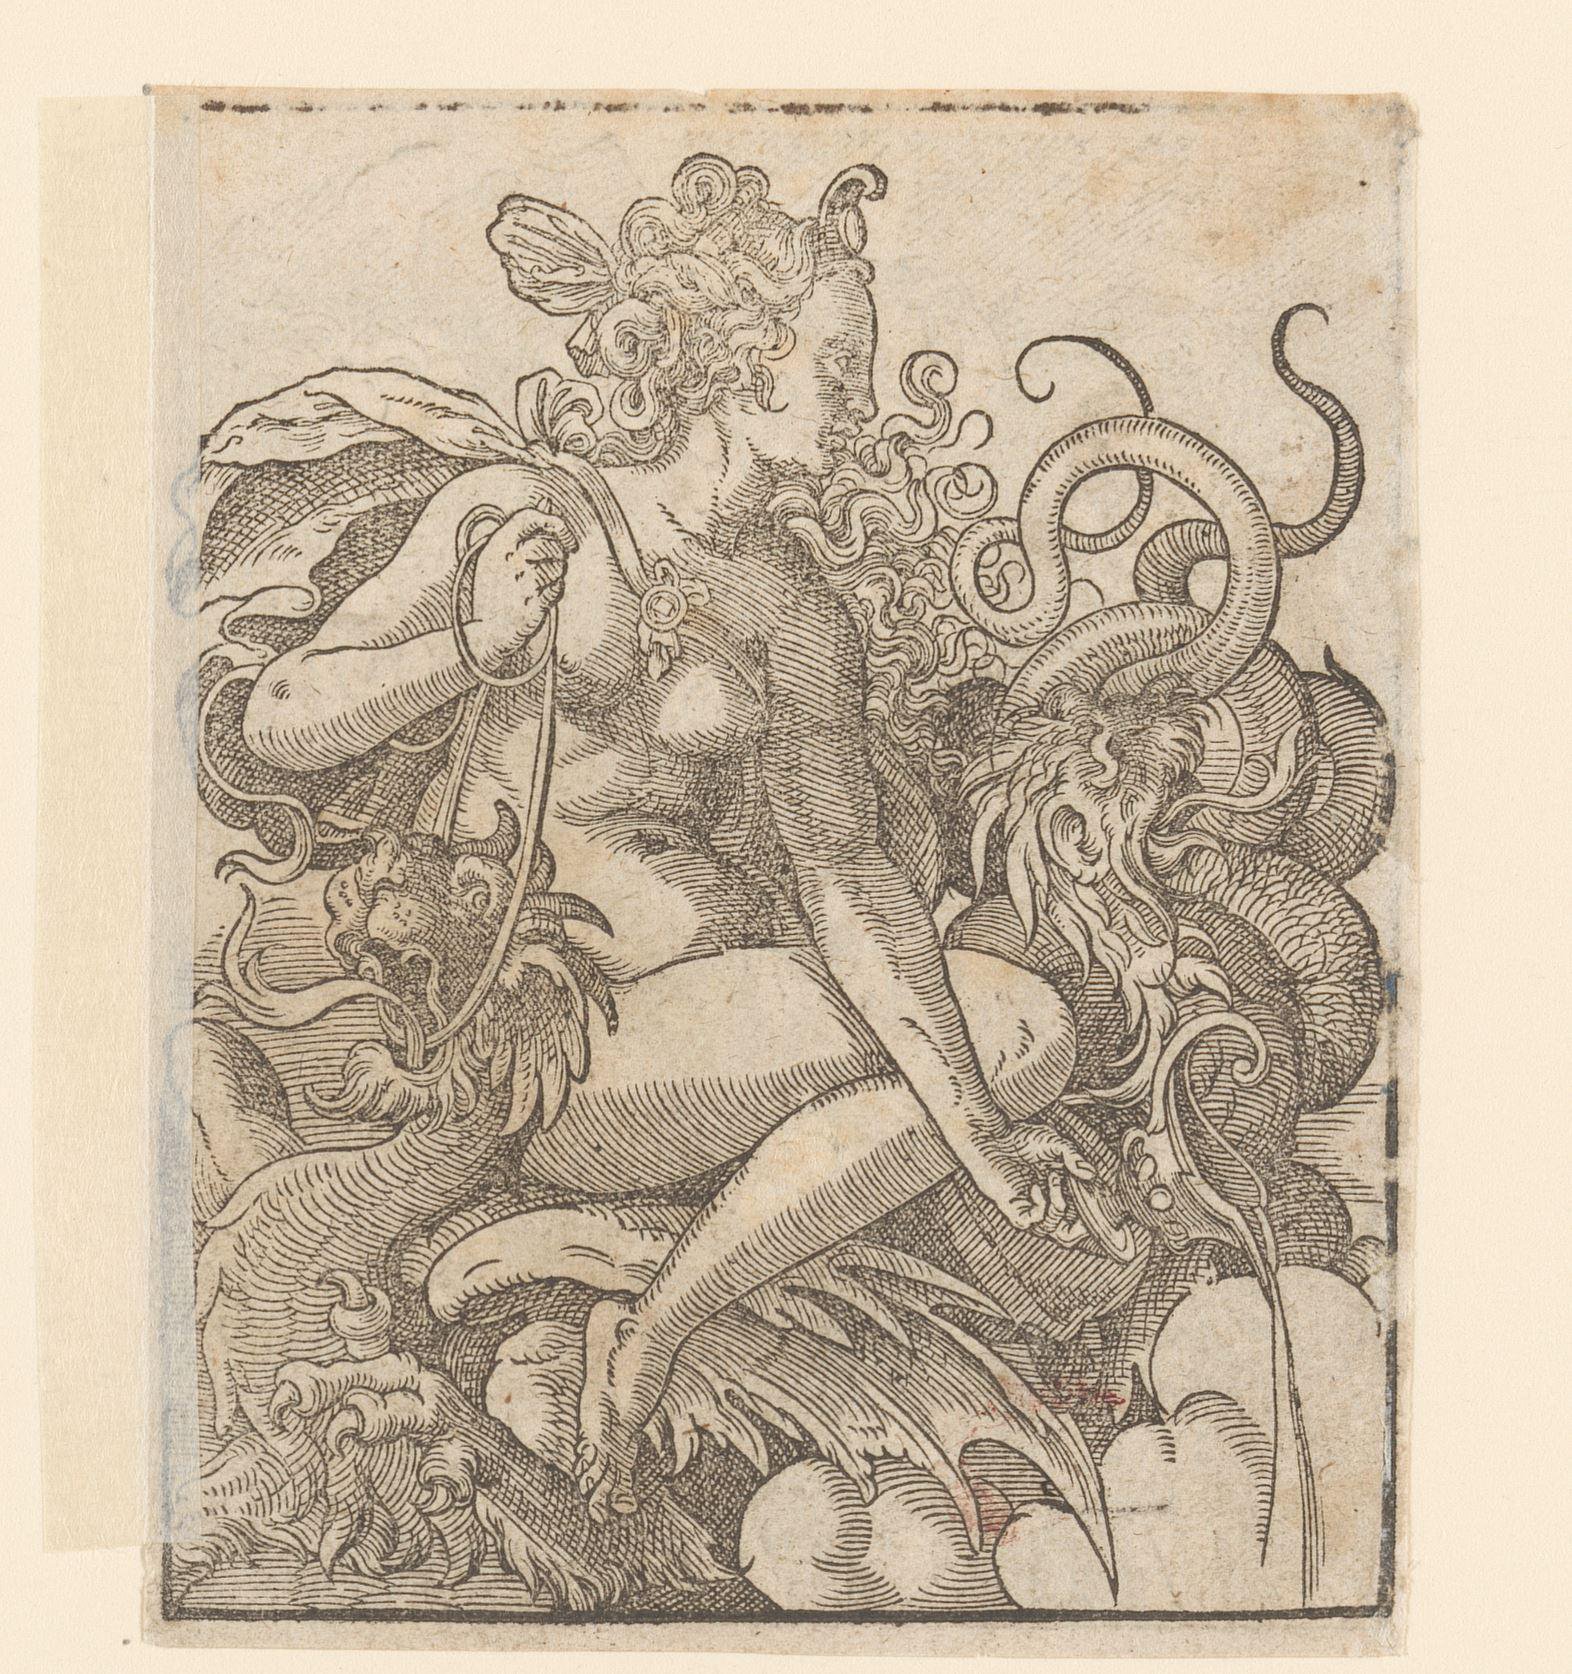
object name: print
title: Medea gedragen door draken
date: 1580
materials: paper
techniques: woodcut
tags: medea kills her two children; she flees from corinth in a chariot drawn by winged dragons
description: Prent ook gebruikt in: Amman, Jost. Kunstbüchlein. Frankfurt am Main: Feyerabend, 1580.